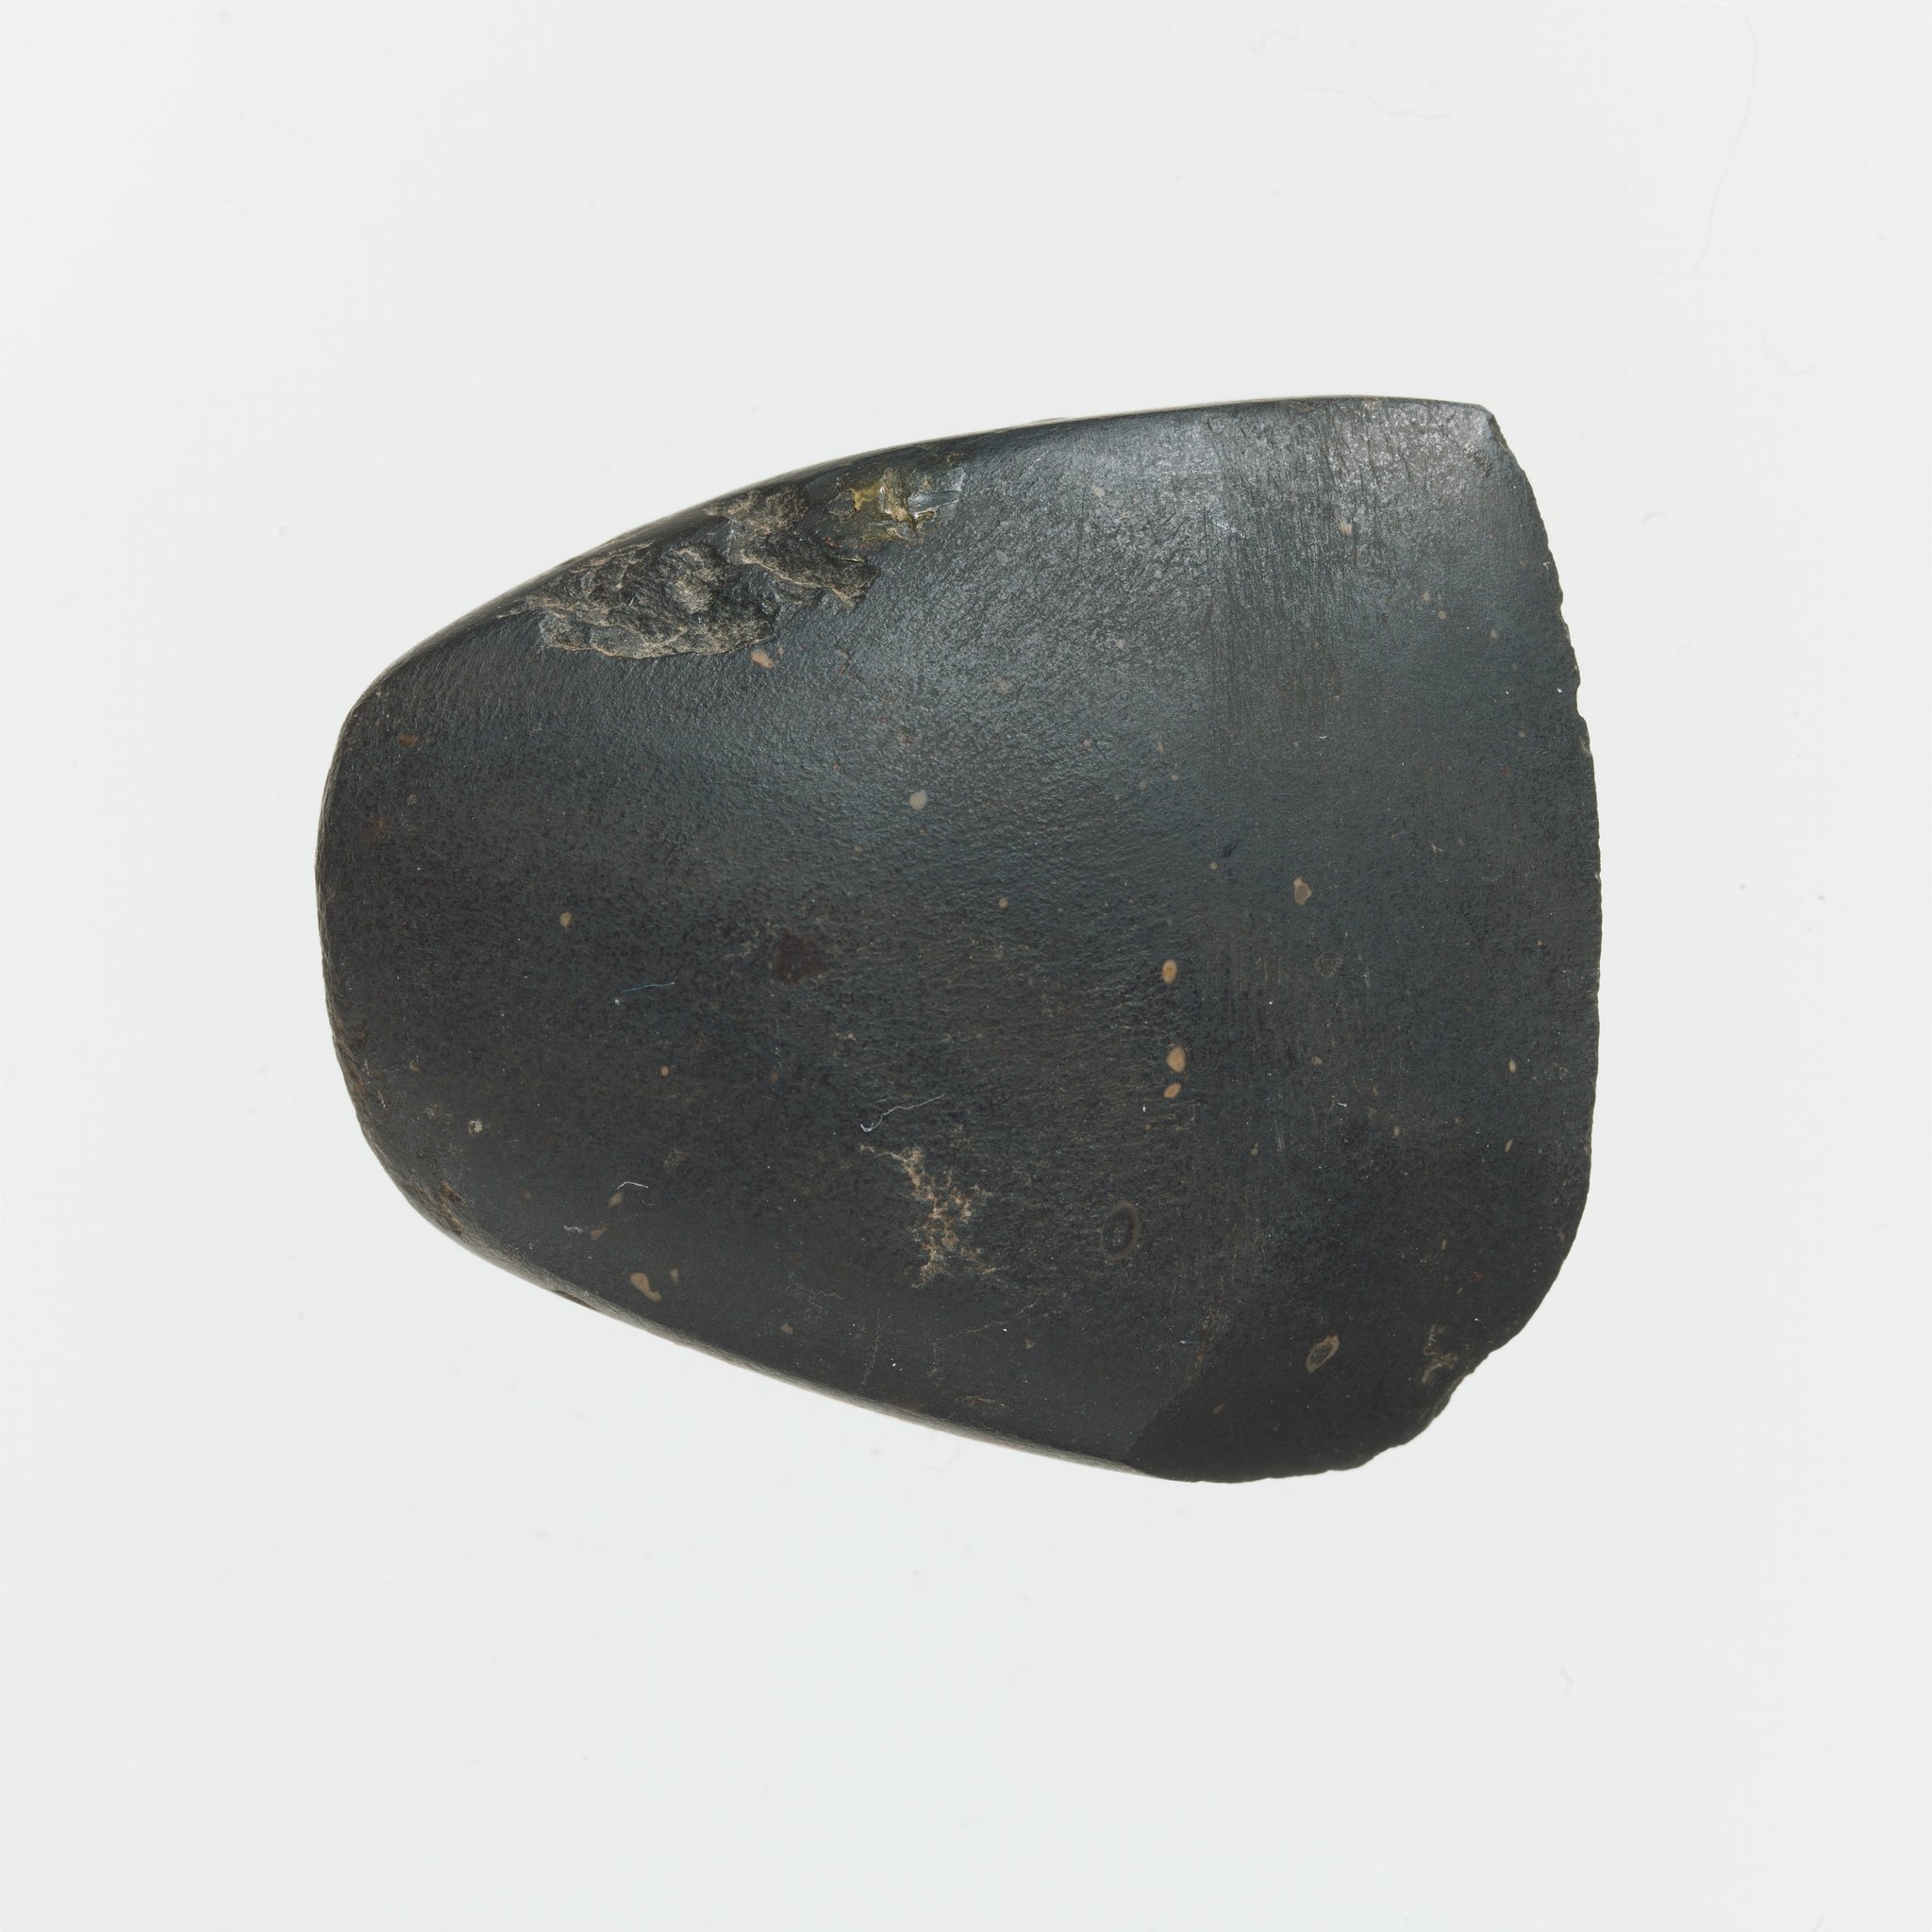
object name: celt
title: Small pisolitic bauxite axe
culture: cretan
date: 5000-3001 BCE